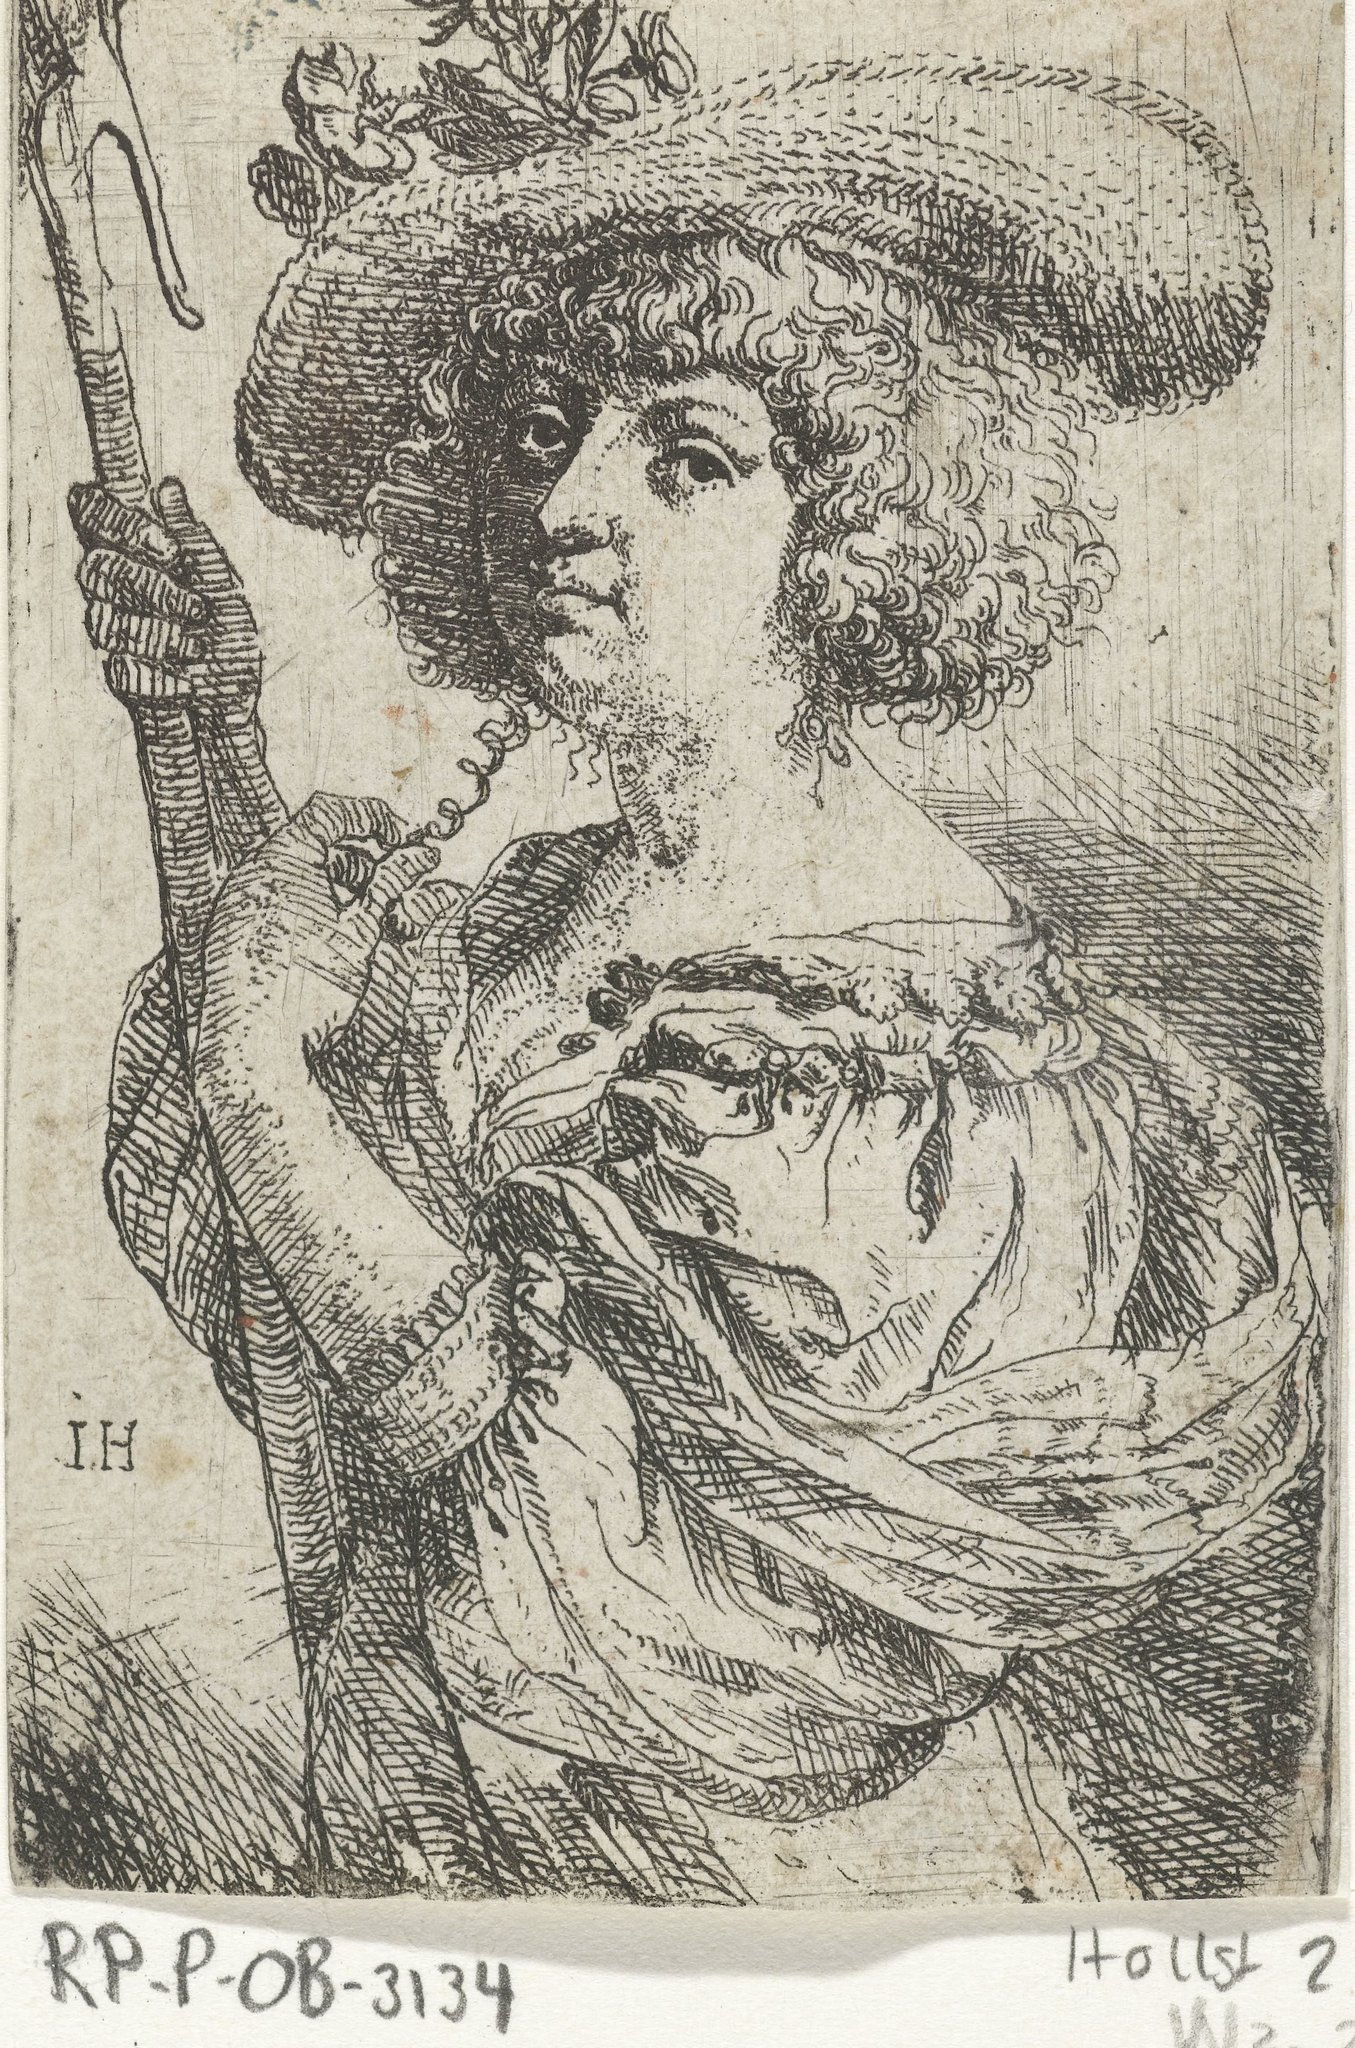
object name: print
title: Herderin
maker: jan van den hoecke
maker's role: painter, print maker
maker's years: 1611-1651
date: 1621-1651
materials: paper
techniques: etching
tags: herding, herdsman, herdswoman, shepherd, shepherdess, cowherd, etc., shepherd's crook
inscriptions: collector's mark: Lugt 2165, collector's mark: Lugt 2228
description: Herderin met een herderinnenstaf, ten halven lijve naar links.